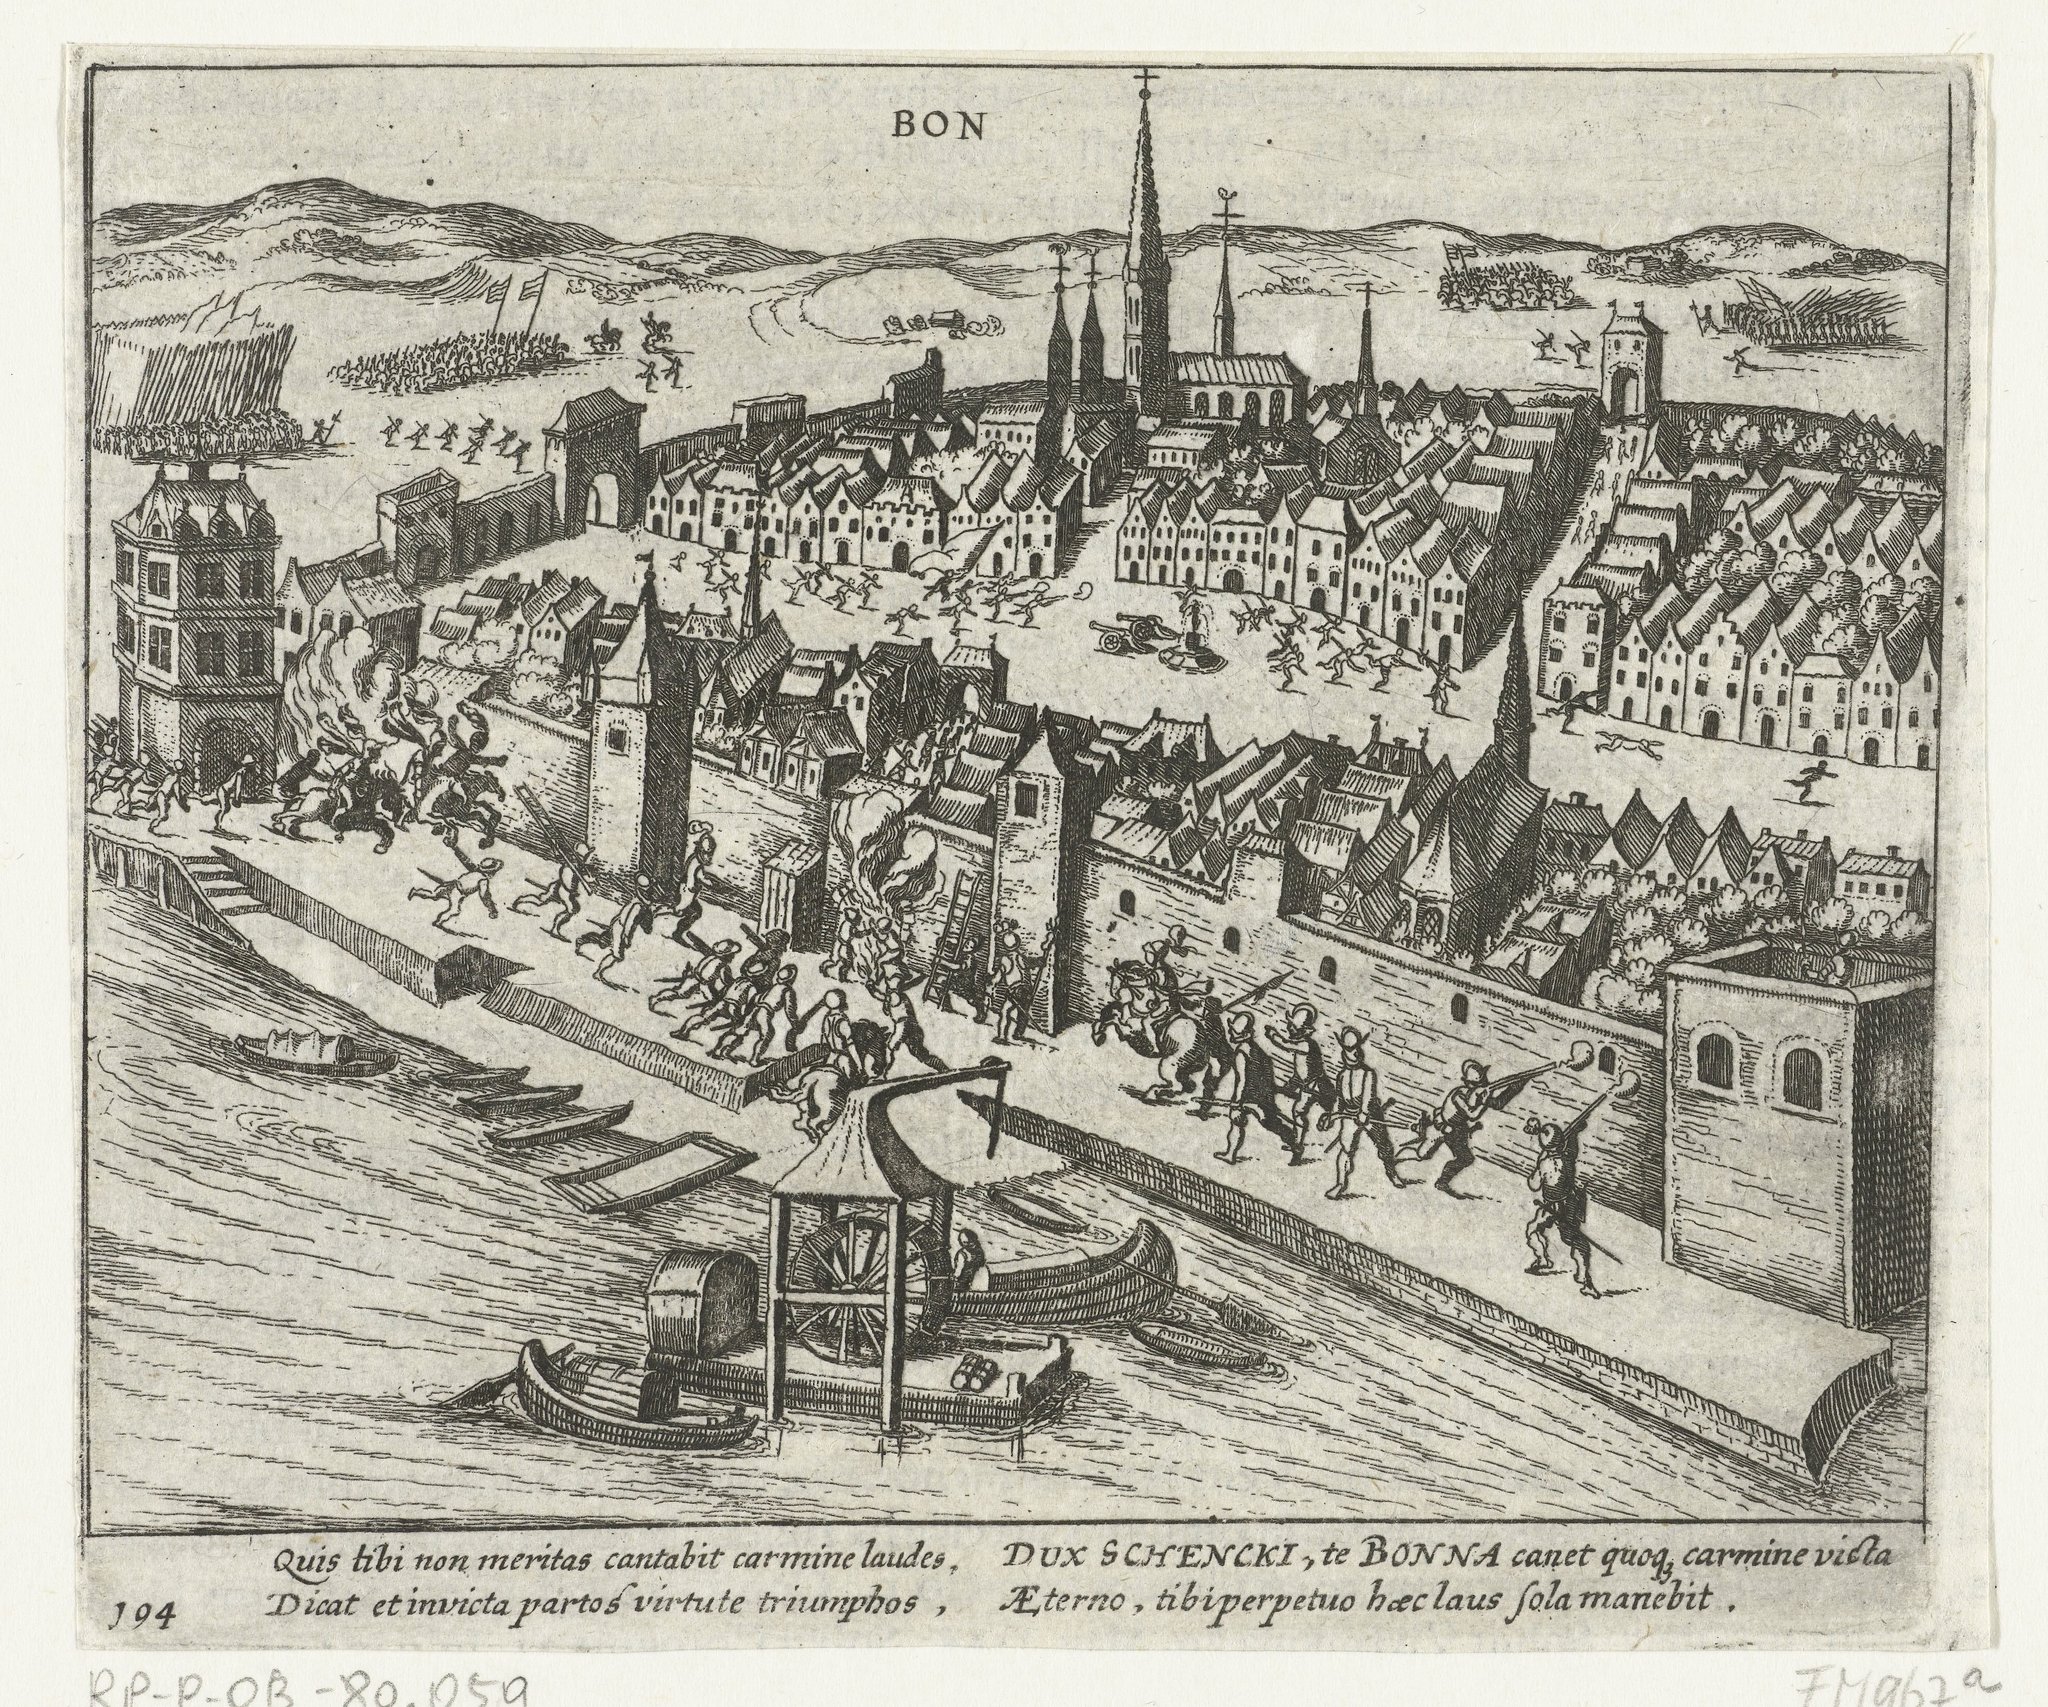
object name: print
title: Bonn door Schenck voor Truchsess gewonnen, 1587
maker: Anonymous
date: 1613-1615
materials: paper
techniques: etching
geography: northern netherlands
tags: capture of city (after the siege)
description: Bonn door Schenck voor Truchsess gewonnen, 23 december 1587. Episode uit de Keulse Oorlog. Met onderschrift van 4 regels in het Latijn. Genummerd 194. Bedrukt op achterzijde met tekst in het Latijn.